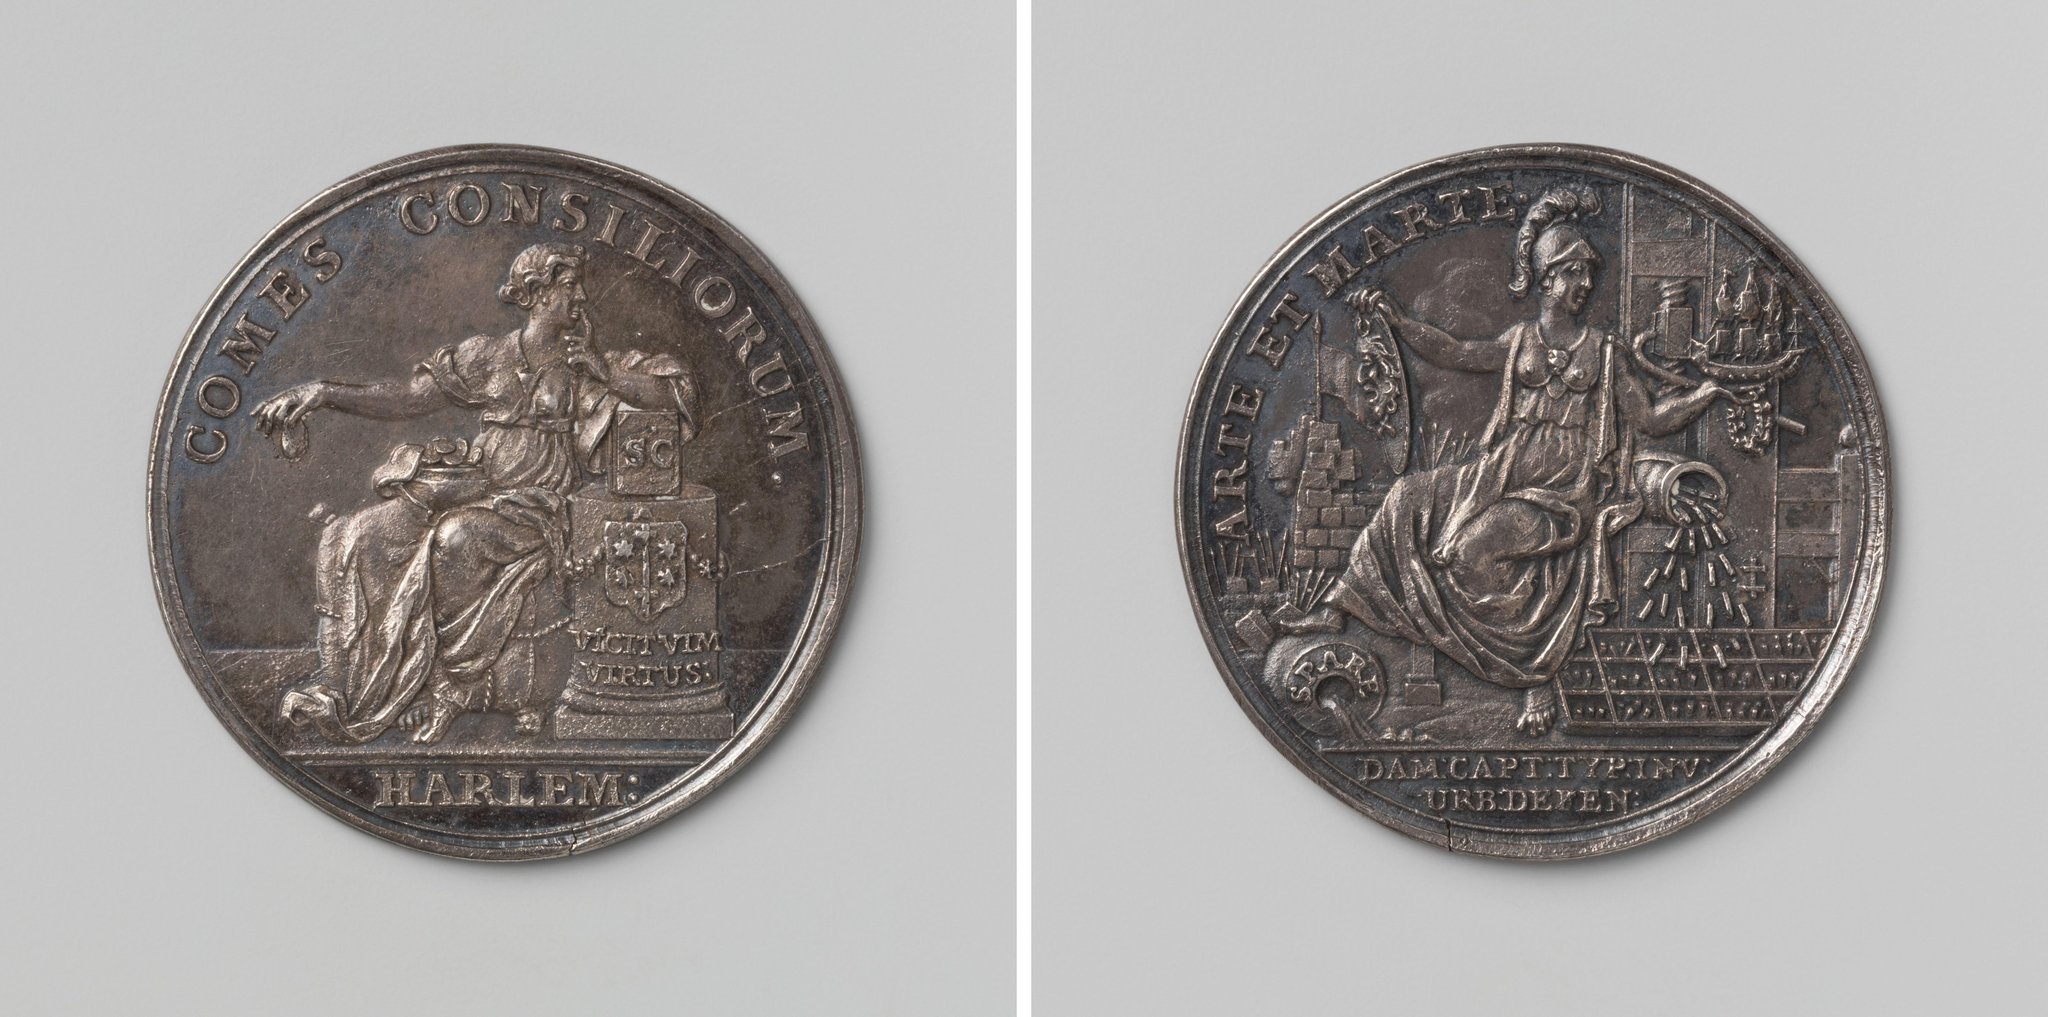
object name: council medal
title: Vroedschapspenning van de stad Haarlem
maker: Anonymous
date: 1740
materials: silver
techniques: striking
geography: haarlem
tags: haarlem